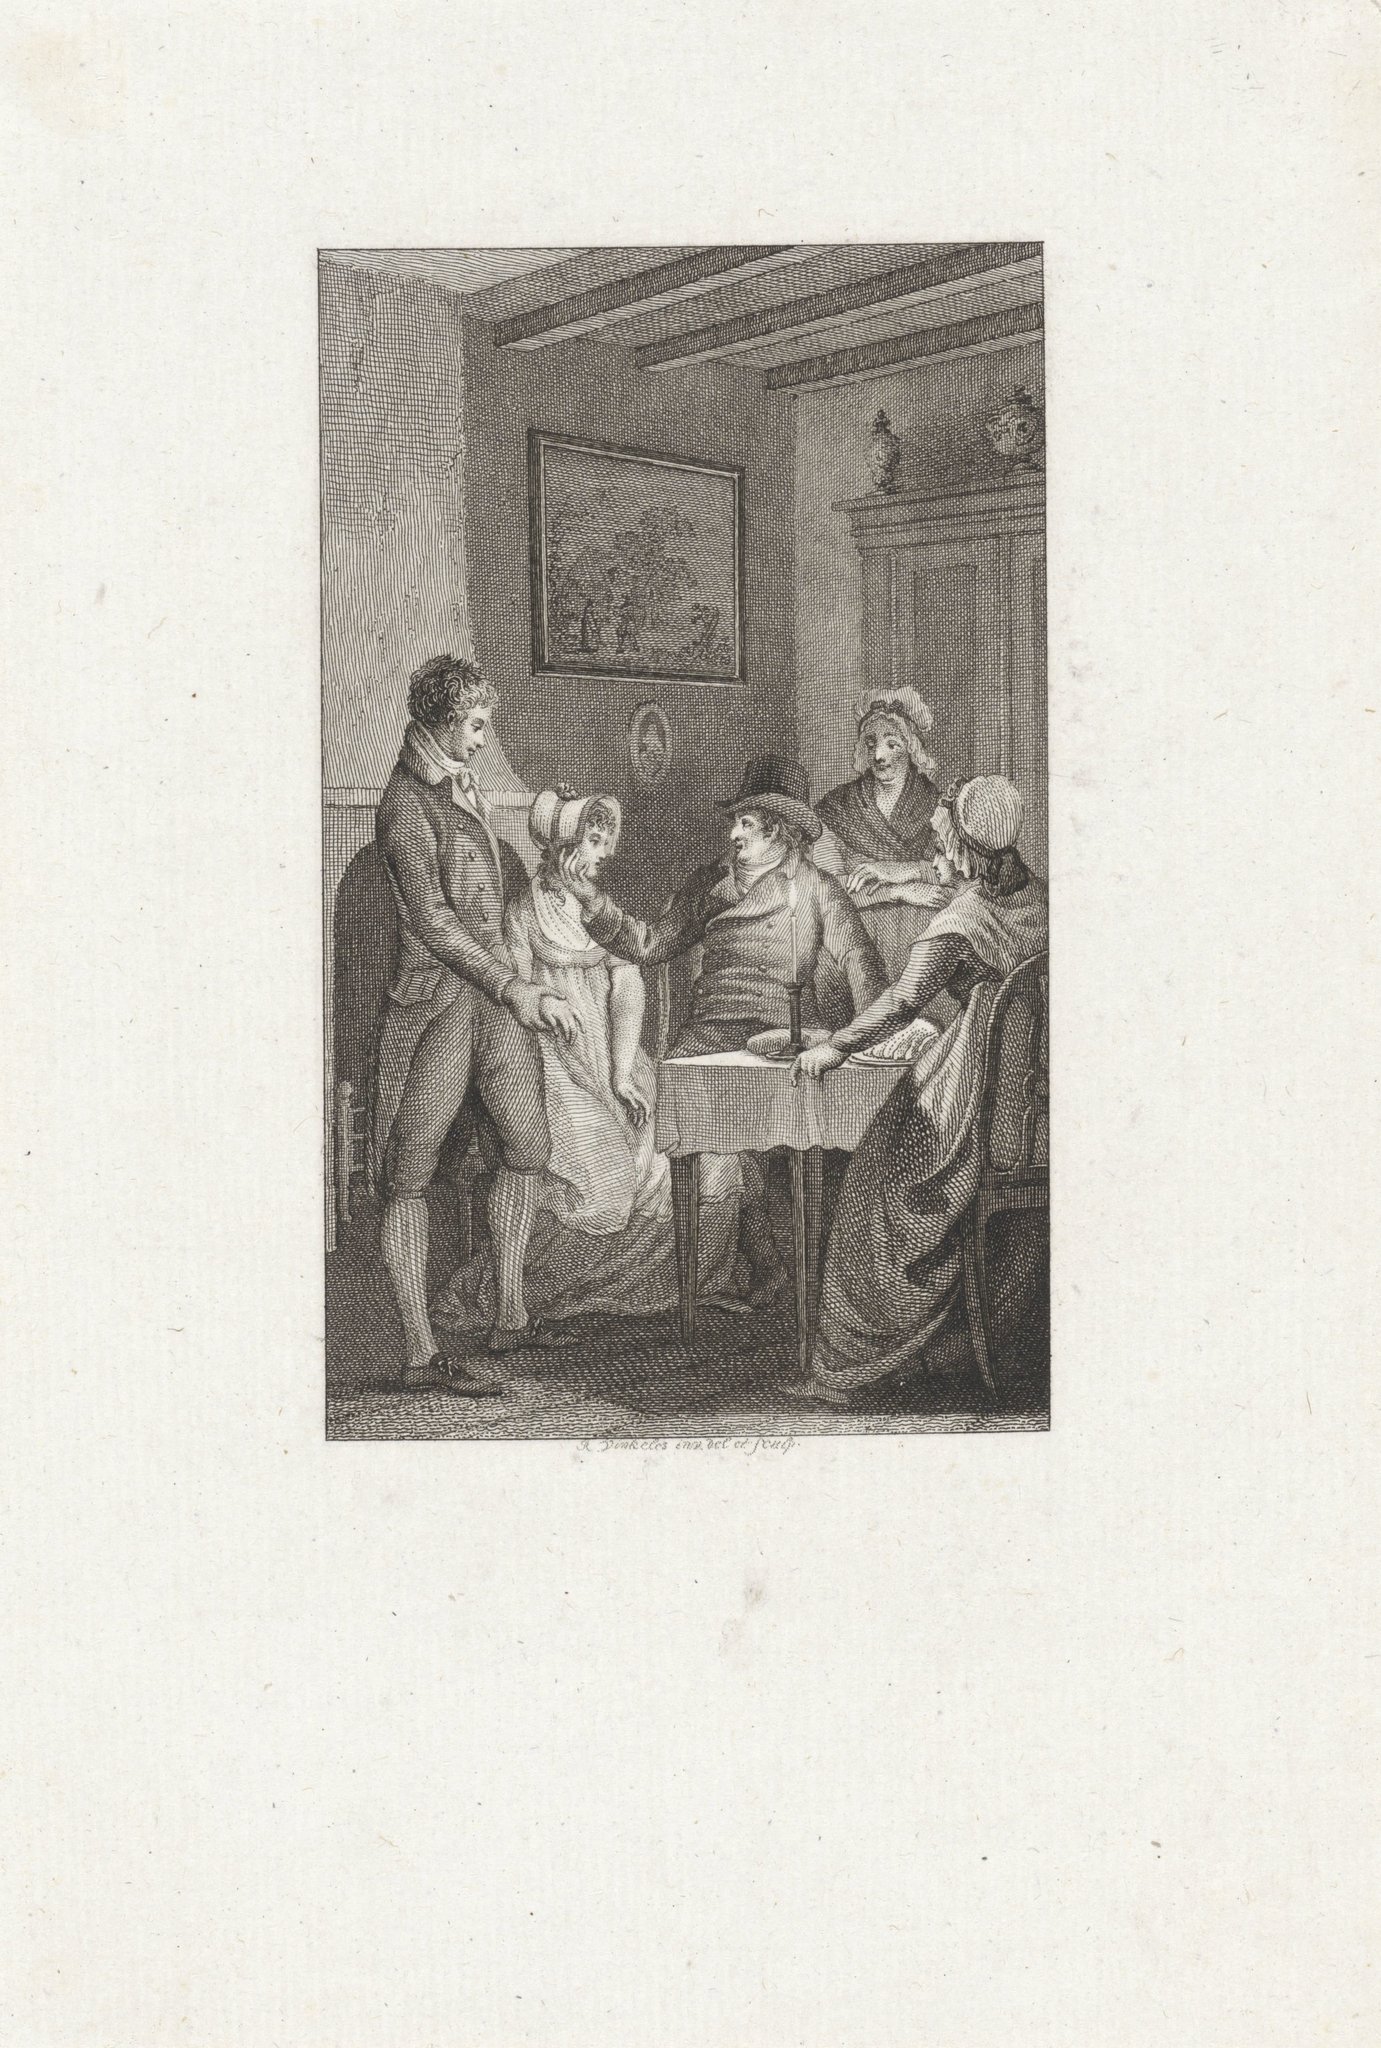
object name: print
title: Gezelschap aan de maaltijd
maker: reinier vinkeles (i)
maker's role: draughtsman, print maker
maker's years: 1741-1816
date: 1797-1811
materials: paper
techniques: engraving, etching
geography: amsterdam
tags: unequal partners (+ variant), open hearth, fire-place, picture, painting, (family) meal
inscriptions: collector's mark: Lugt 240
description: Deze prent is ook als illustratie gebruikt in: Magazijn van Geschiedenissen, romans en verhalen, 25 delen. Rotterdam: Jan Meyer, 1790-1798 en Amsterdam: Johannes Allart, 1798-1811.